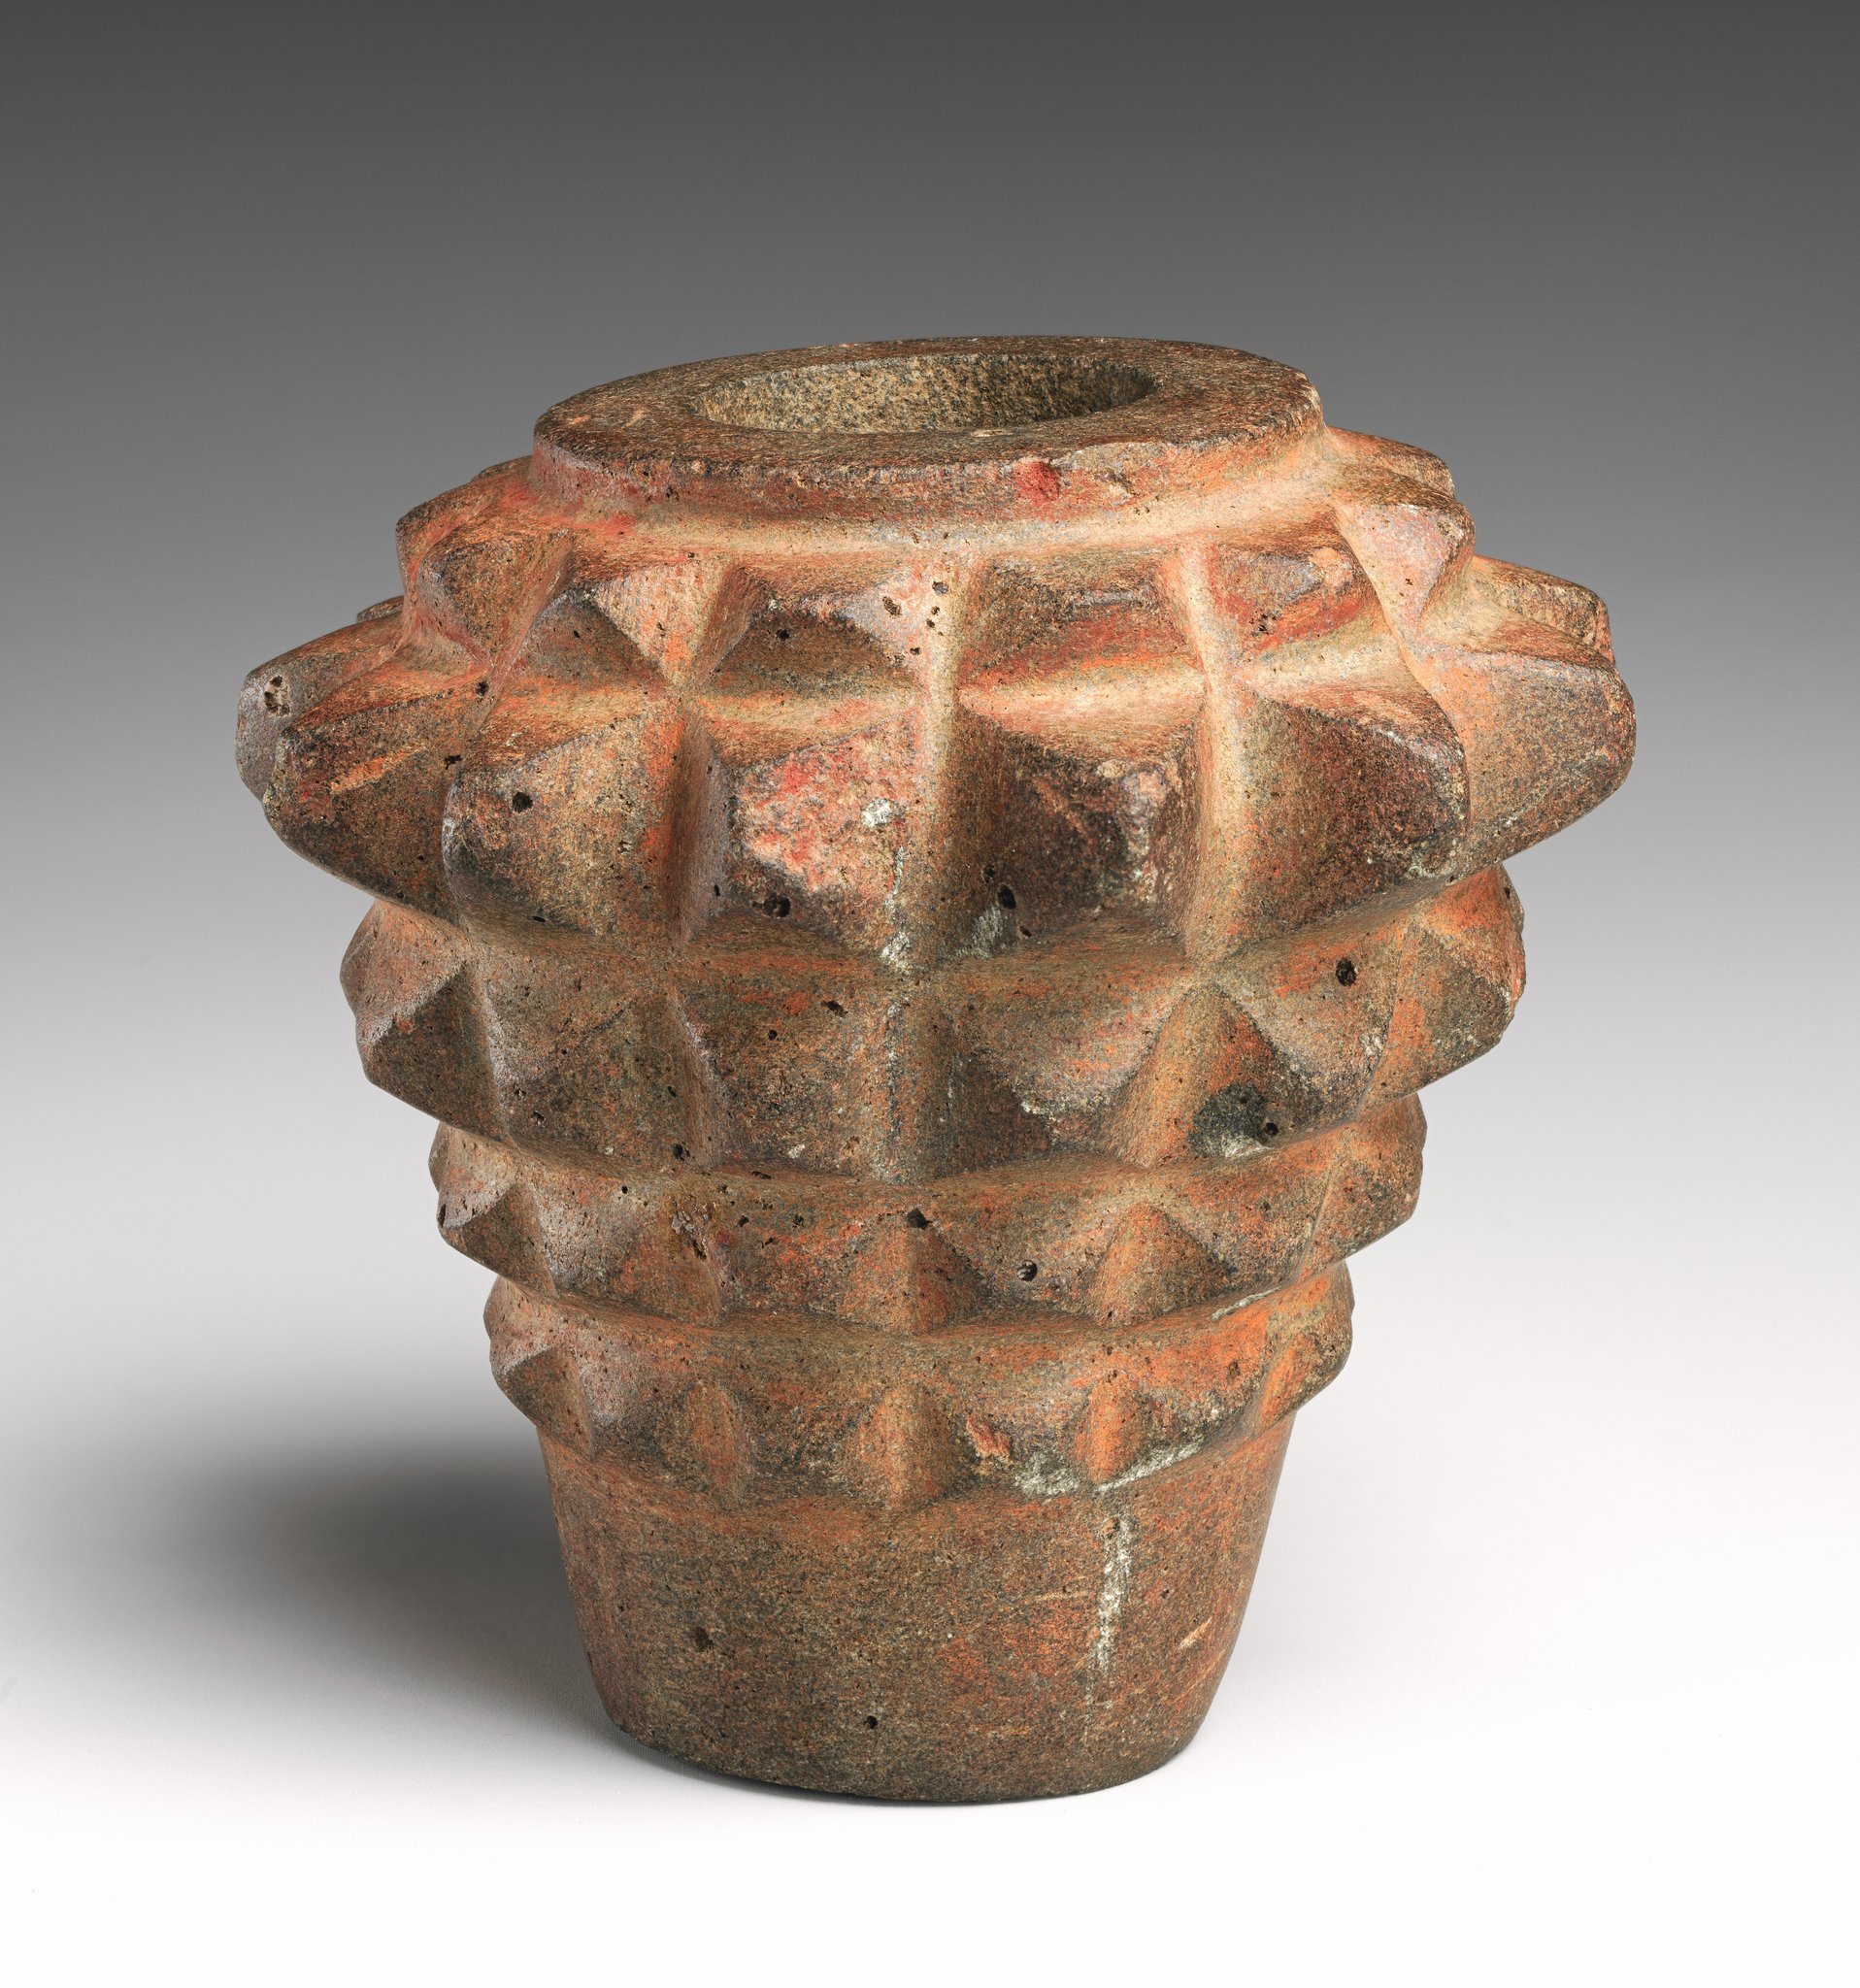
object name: mace head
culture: salinar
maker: salinar artist(s)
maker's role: artist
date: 500-100 BCE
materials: pigment, stone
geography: peru